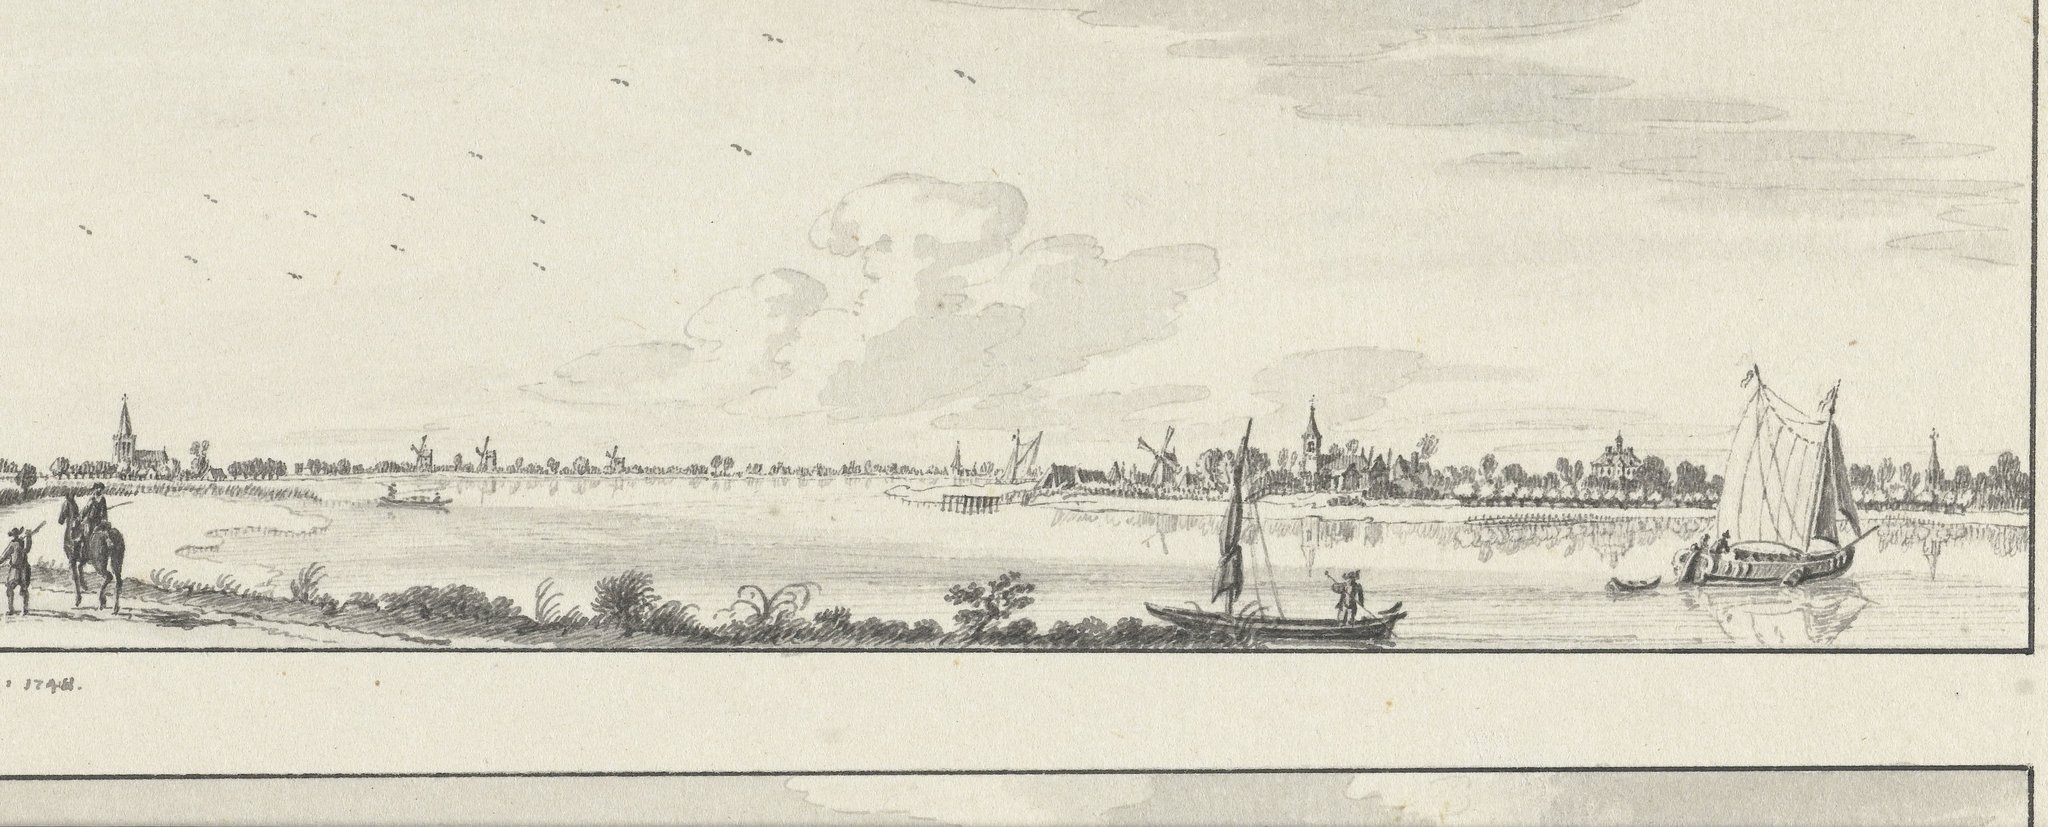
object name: drawing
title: Gezicht over de Lek op de dorpen Lopik, Jaarsveld, Tienhoven, Ameide en het Huis Herlaer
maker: jan de beijer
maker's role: draughtsman, print maker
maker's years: 1703-1780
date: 1745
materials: ink, paper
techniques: brush, pen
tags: river, jaarsveld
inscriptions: : ‘Gesigt van den hoogen Dijk over de Lek op de dorpen Lopik, Jaersveld, Tienhoven, Amejde en het Hujs Herlaer’